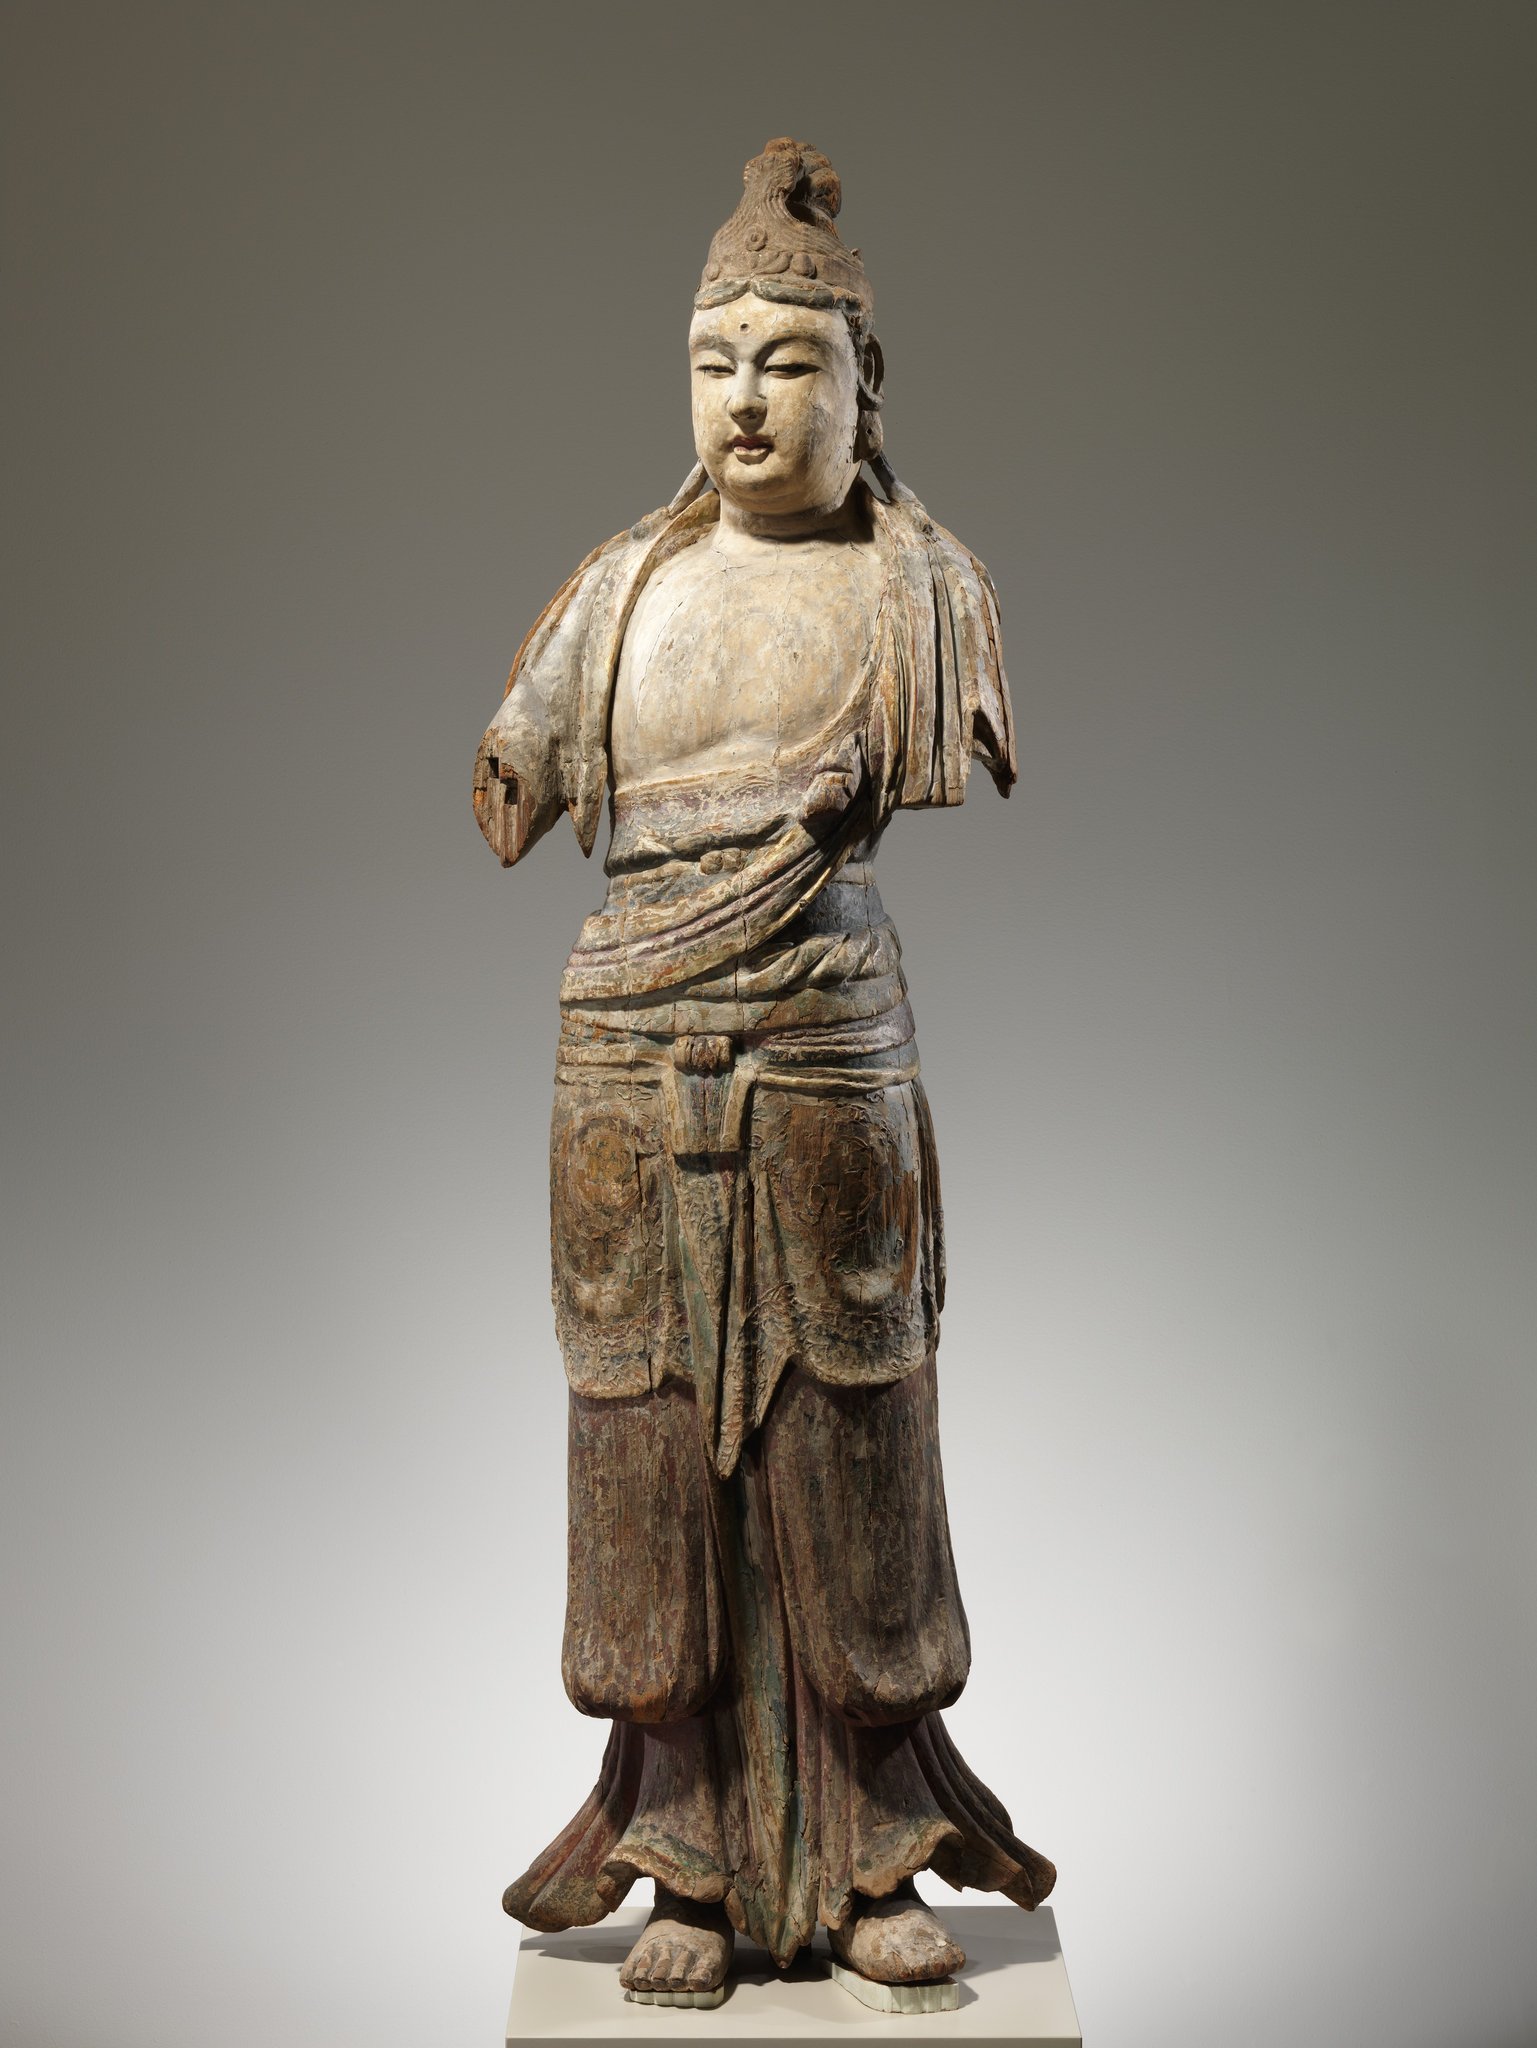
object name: statue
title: Bodhisattva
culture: chinese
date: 1001-1200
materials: pigment, wood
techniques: gilding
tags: buddhism,bodhisattvas